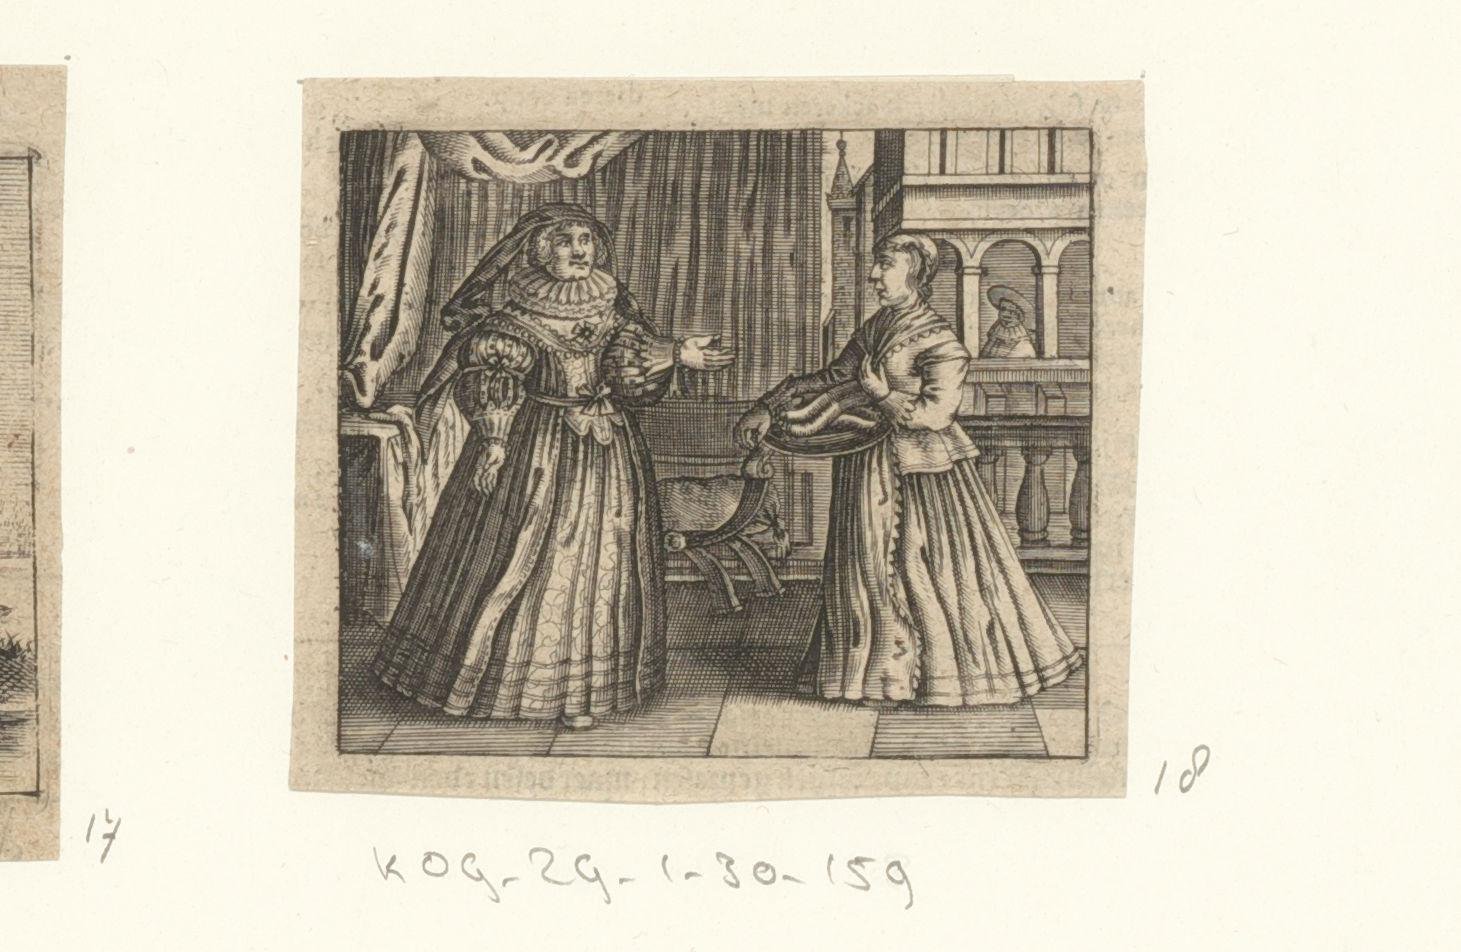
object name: print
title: Rijke vrijster spreekt met een kamermeid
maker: Anonymous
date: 1635-1715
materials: paper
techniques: engraving, letterpress printing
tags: single woman, spinster, proverbs, sayings, etc., maid ~ house personnel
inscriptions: stamp, collector's mark: Lugt 1641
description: Veel versies van dit embleem verschenen in verschillende uitgave van Spiegel van den Ouden ende Nieuwen Tydt. Zoals: Cats, Jacob. Spiegel van den Ouden ende Nieuwen-tijt, Bestaende uyt Spreeck-woorden (...). Dordrecht: Jacob Braat, 1647. Maar ook in andere publicaties (1665, 1671, 1715, 1722).